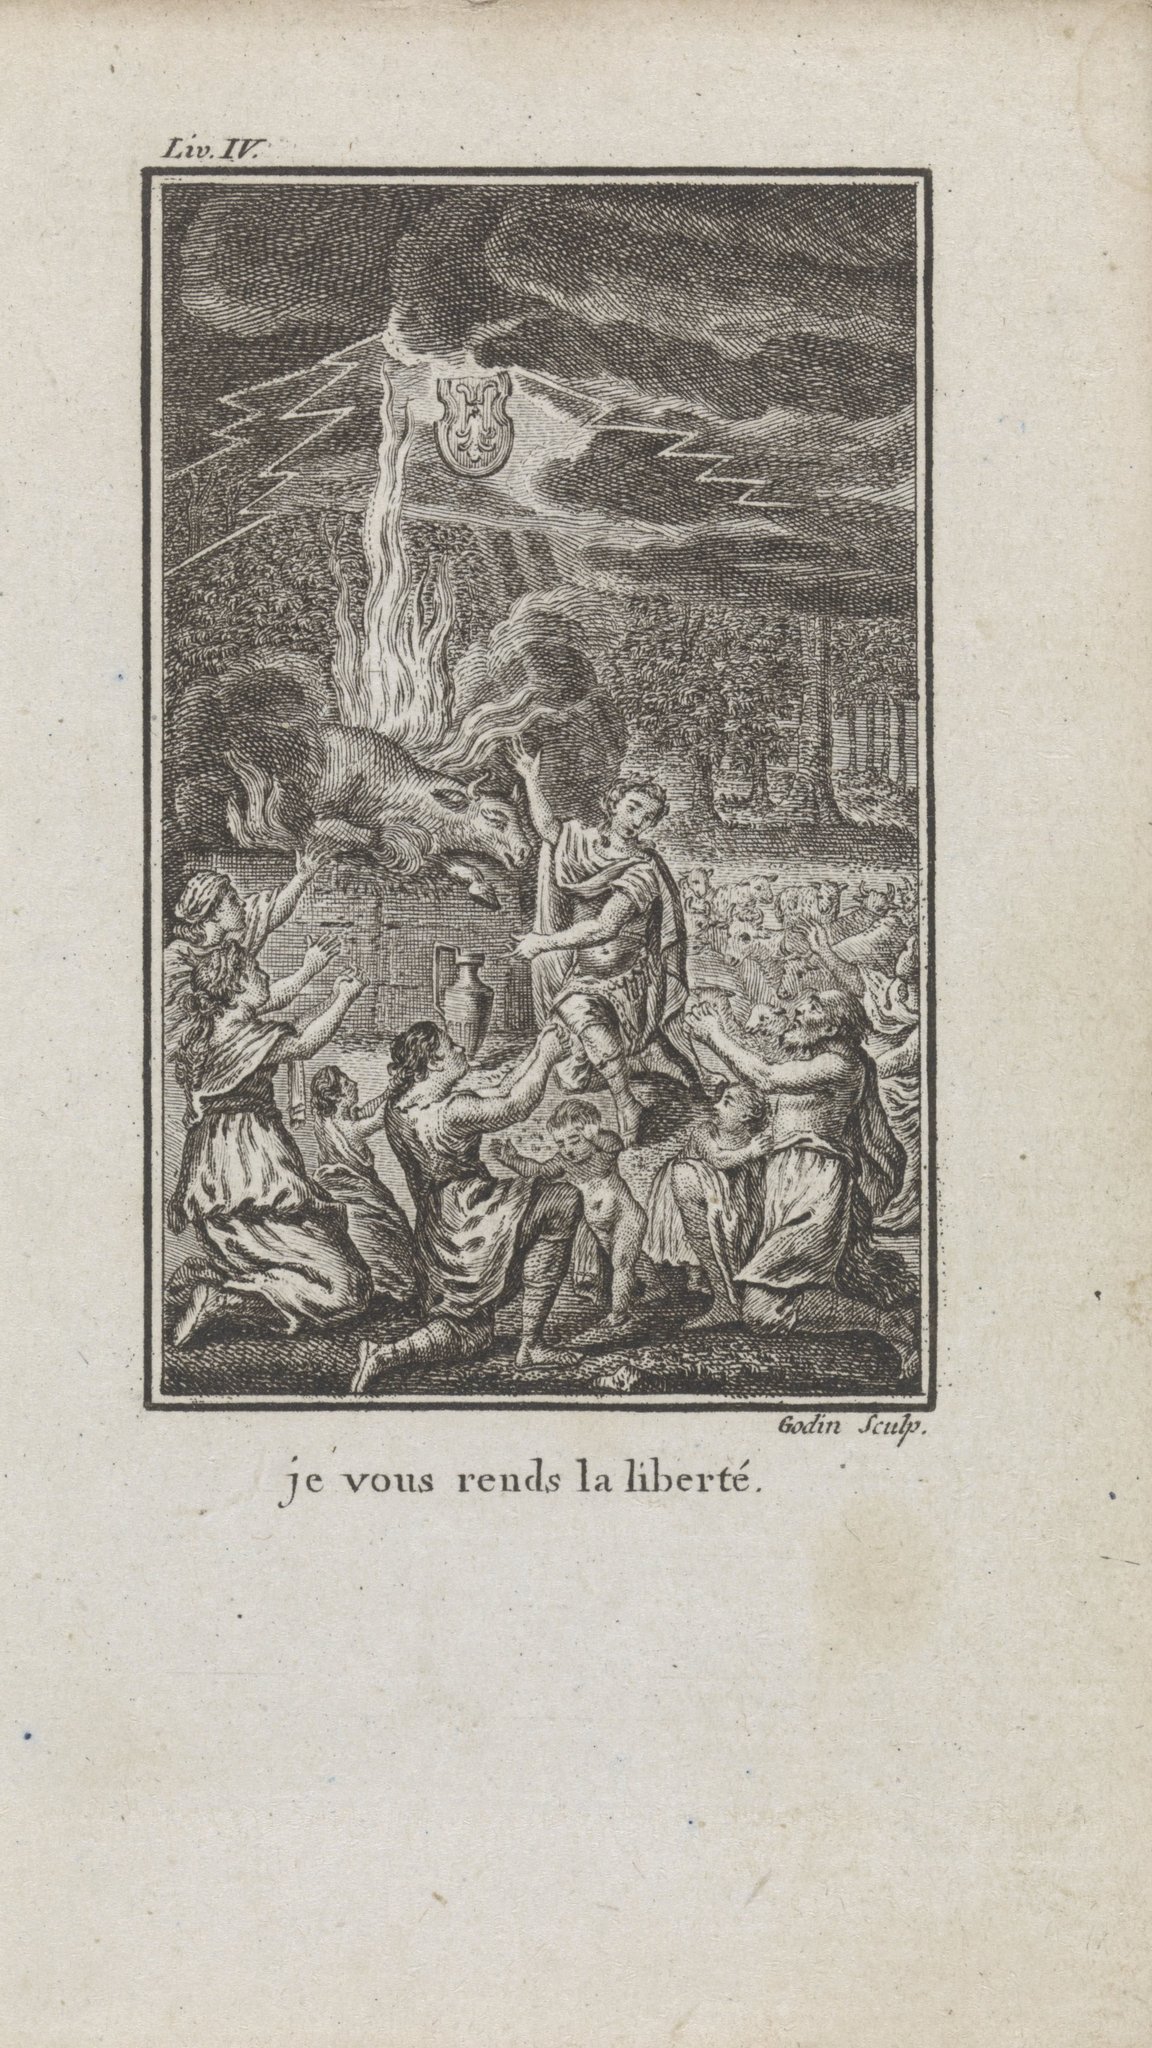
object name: print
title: Tijdens een offerande wordt Numa door Ceres beloond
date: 1790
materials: paper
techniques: engraving, letterpress printing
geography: liège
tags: protective weapons: shield, (story of) ceres (demeter), liberating prisoners of war, animal sacrifice ~ roman religion, slavery; serfs and enslaved persons, male literary characters (with name)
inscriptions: collector's mark: Lugt 2228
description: Na de veldslag offert Numa een stier aan de godin Ceres. Hij wordt beloond met een hemels schild, dat uit de hemel neerdaalt. Op de voorgrond de tot slaaf gemaakte gevangenen die Numa bevrijdt. Met een Frans onderschrift.